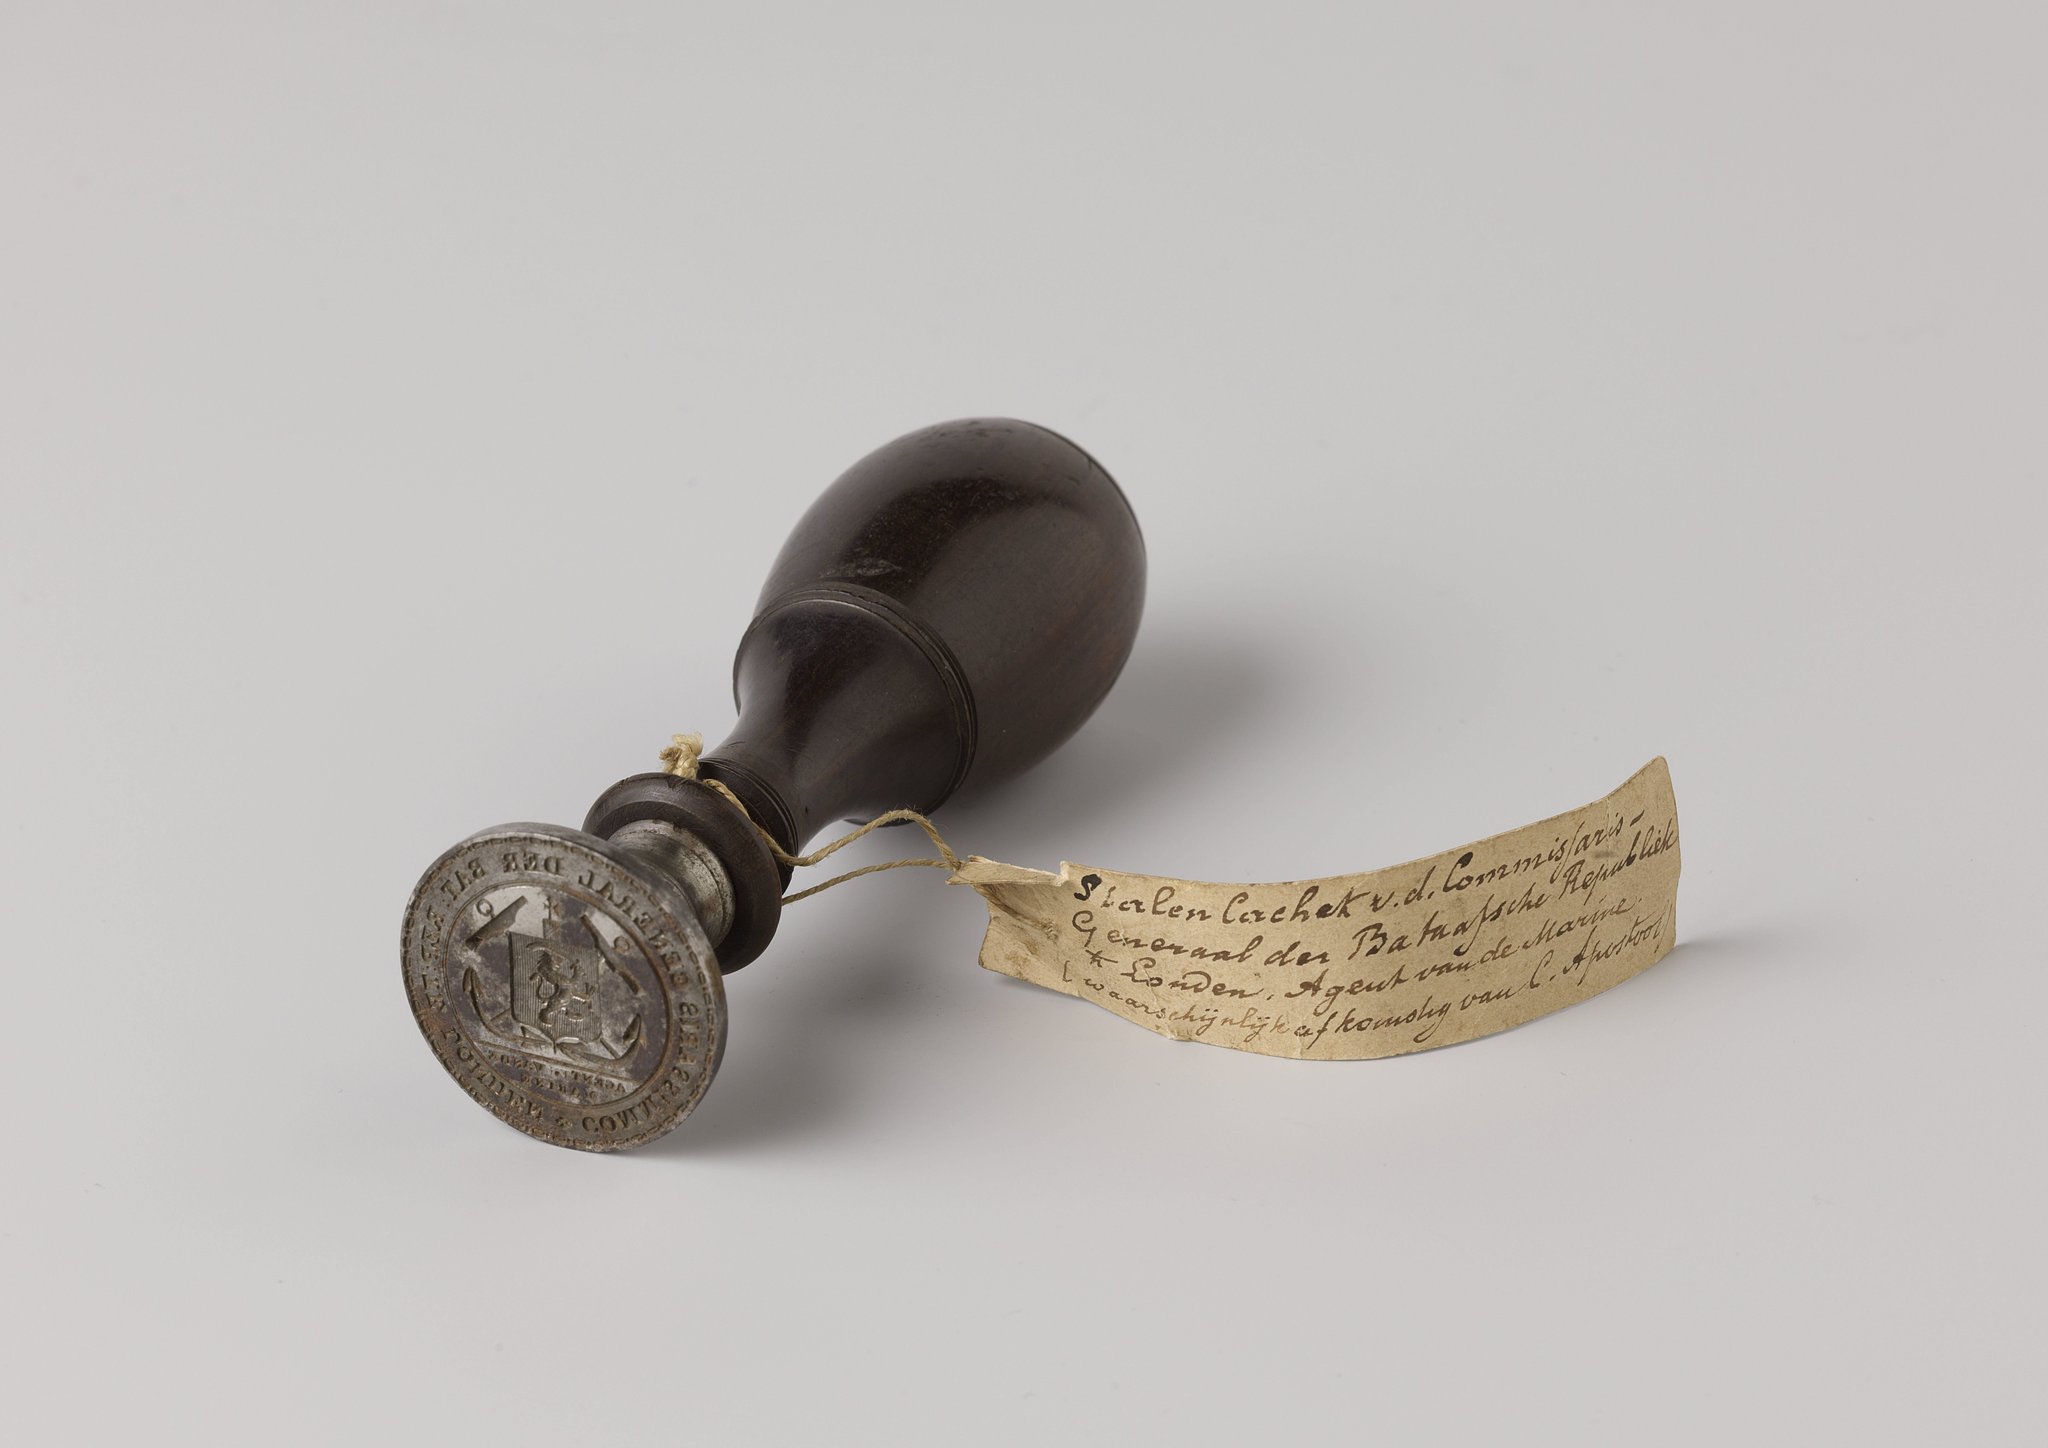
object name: stamp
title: Zegelstempel van staal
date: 1795-1806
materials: steel, wood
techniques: striking, turning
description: Stalen zegelstempel (van de agent van marine van het commissariaat-generaal van de Bataafse Republiek te Londen) met houten handvat. Rond. Gemerkt: op stempelvlak: wapenschild met staande leeuw die zwaard heft. Opschrift: op stempelvlak, spiegelbeeldig: 'COMMISARIS GENERAL DER BAT: REP: TE LONDEN' en 'AGENT VANDE MARINE'.